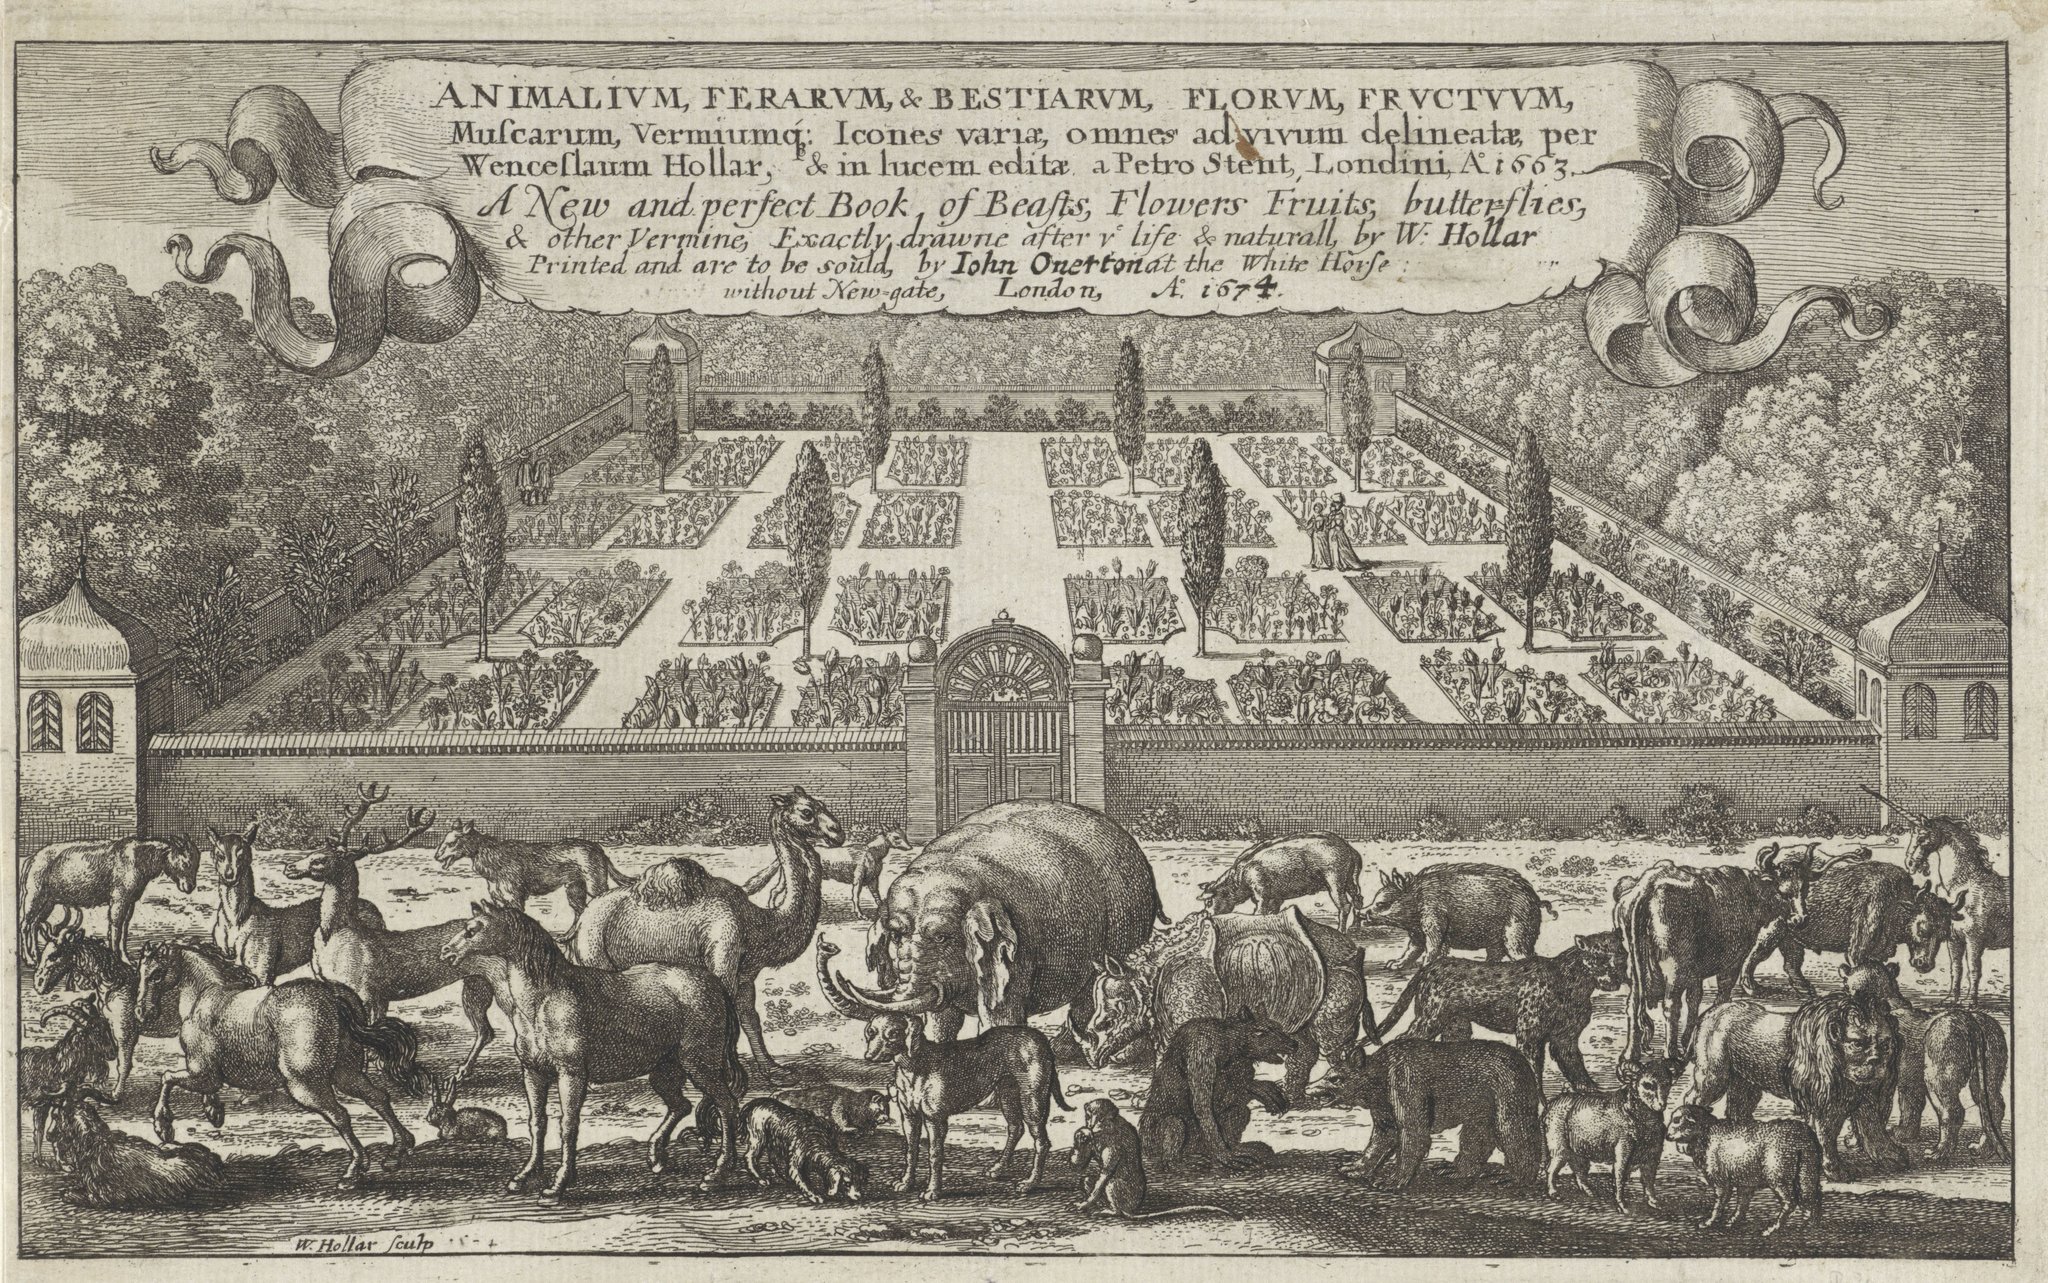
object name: titelprent, frontispice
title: Titelprent voor een serie met planten en dieren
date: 1663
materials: paper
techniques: etching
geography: london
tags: plants; vegetation, animals, french or architectonic garden; formal garden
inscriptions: collector's mark: Lugt 2228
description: Zicht op een ommuurde tuin, opgedeeld in bloemperken. Op de voorgrond uiteenlopende soorten dieren.